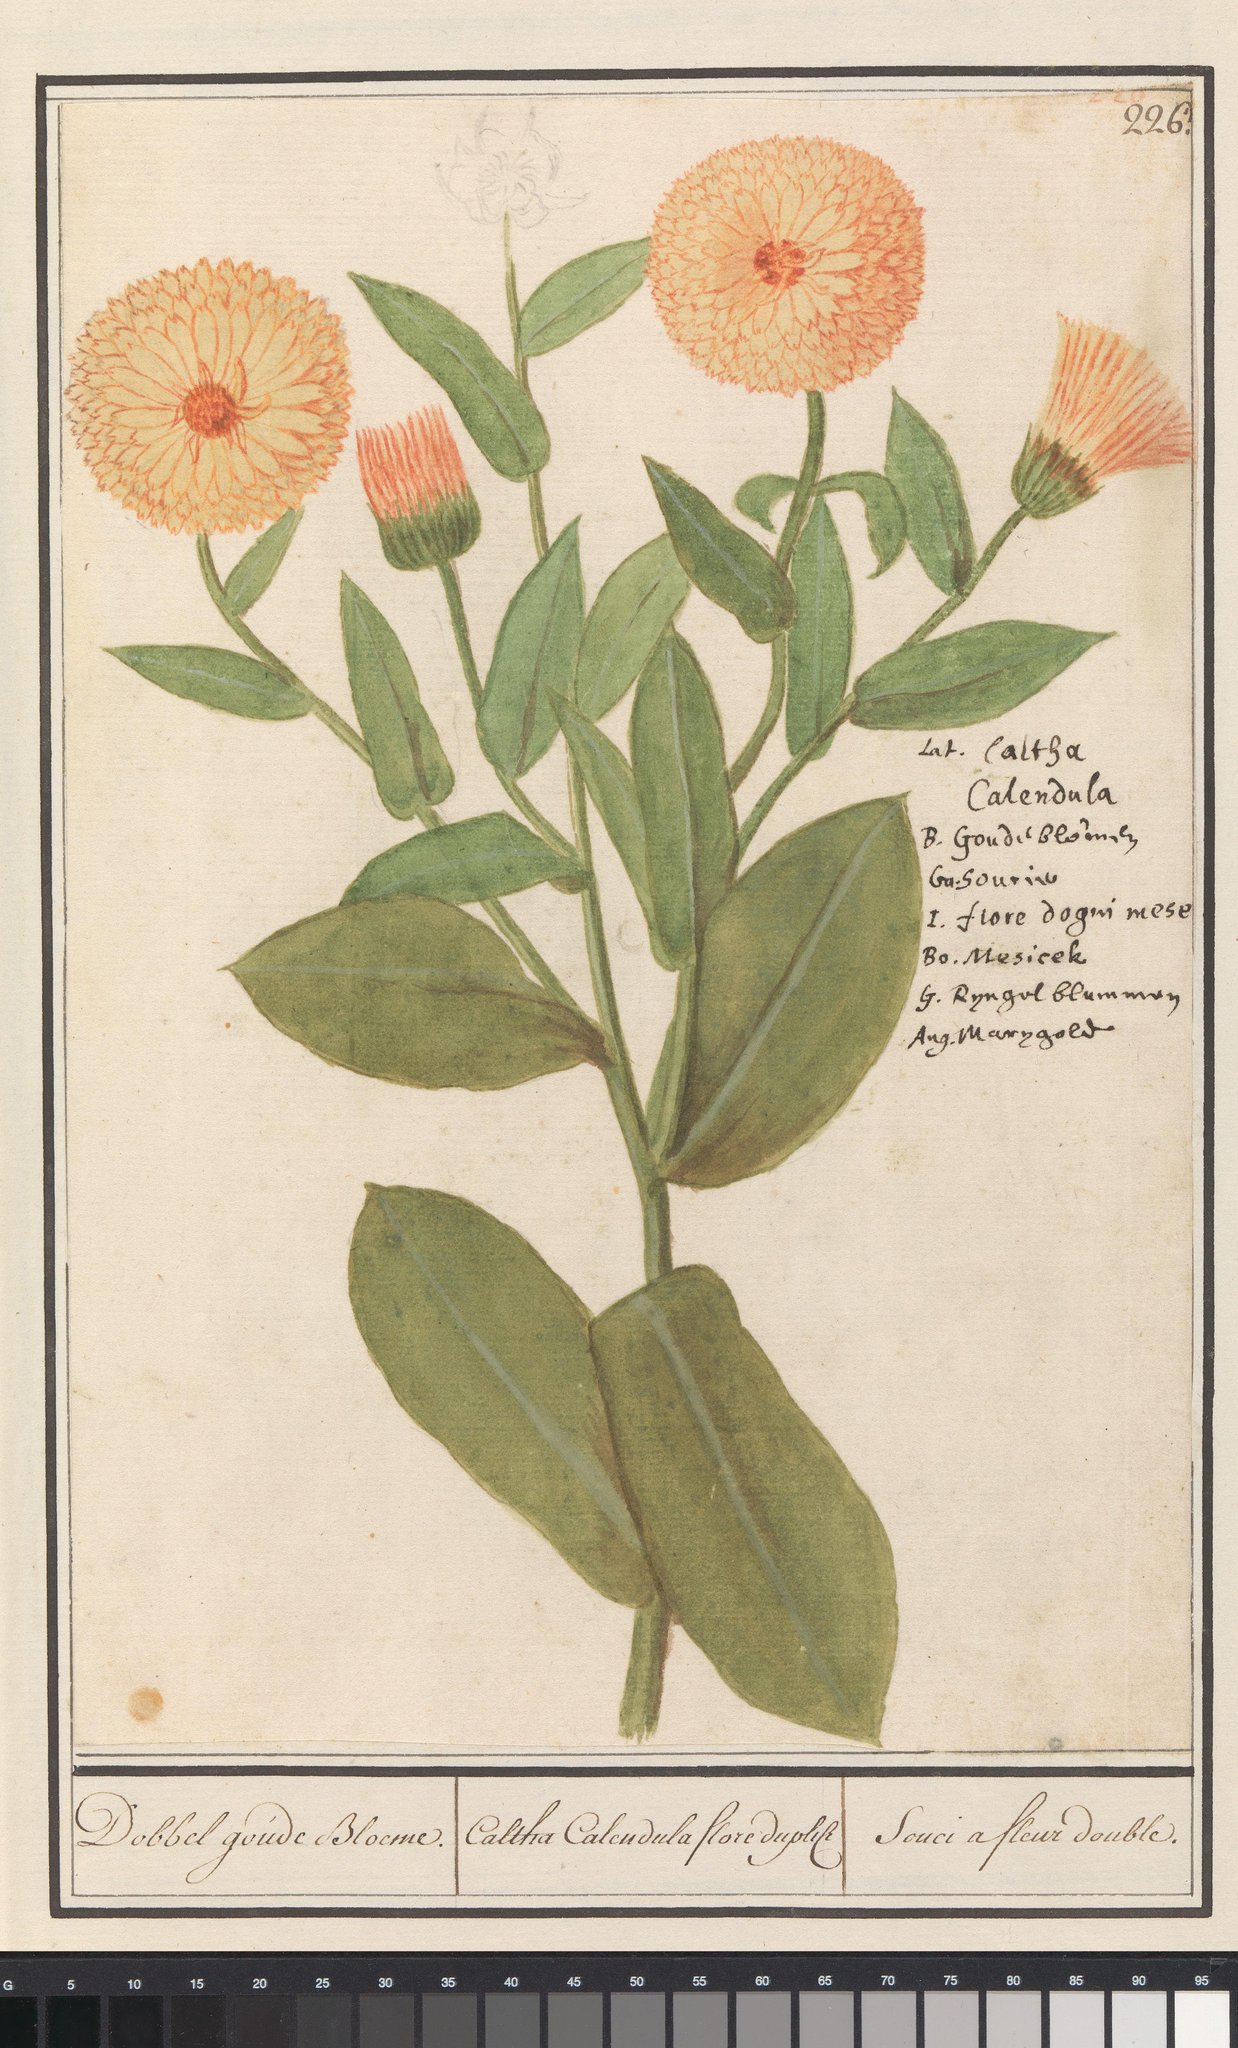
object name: drawing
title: Dobbel goude Bloeme. / Caltha Calendula flore duplice / Souci a fleur double.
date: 1596-1610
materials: chalk, paint, ink, paper, watercolor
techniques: brush, pen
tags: flowers: calendula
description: Goudsbloem. Genummerd rechtsboven: 226. Rechts de naam in zes talen. Onderdeel van het derde album met tekeningen van bloemen en planten. Tiende van twaalf albums met tekeningen van dieren, vogels en planten bekend rond 1600, gemaakt in opdracht van keizer Rudolf II. Met toelichting in Nederlands, Latijn en Frans.